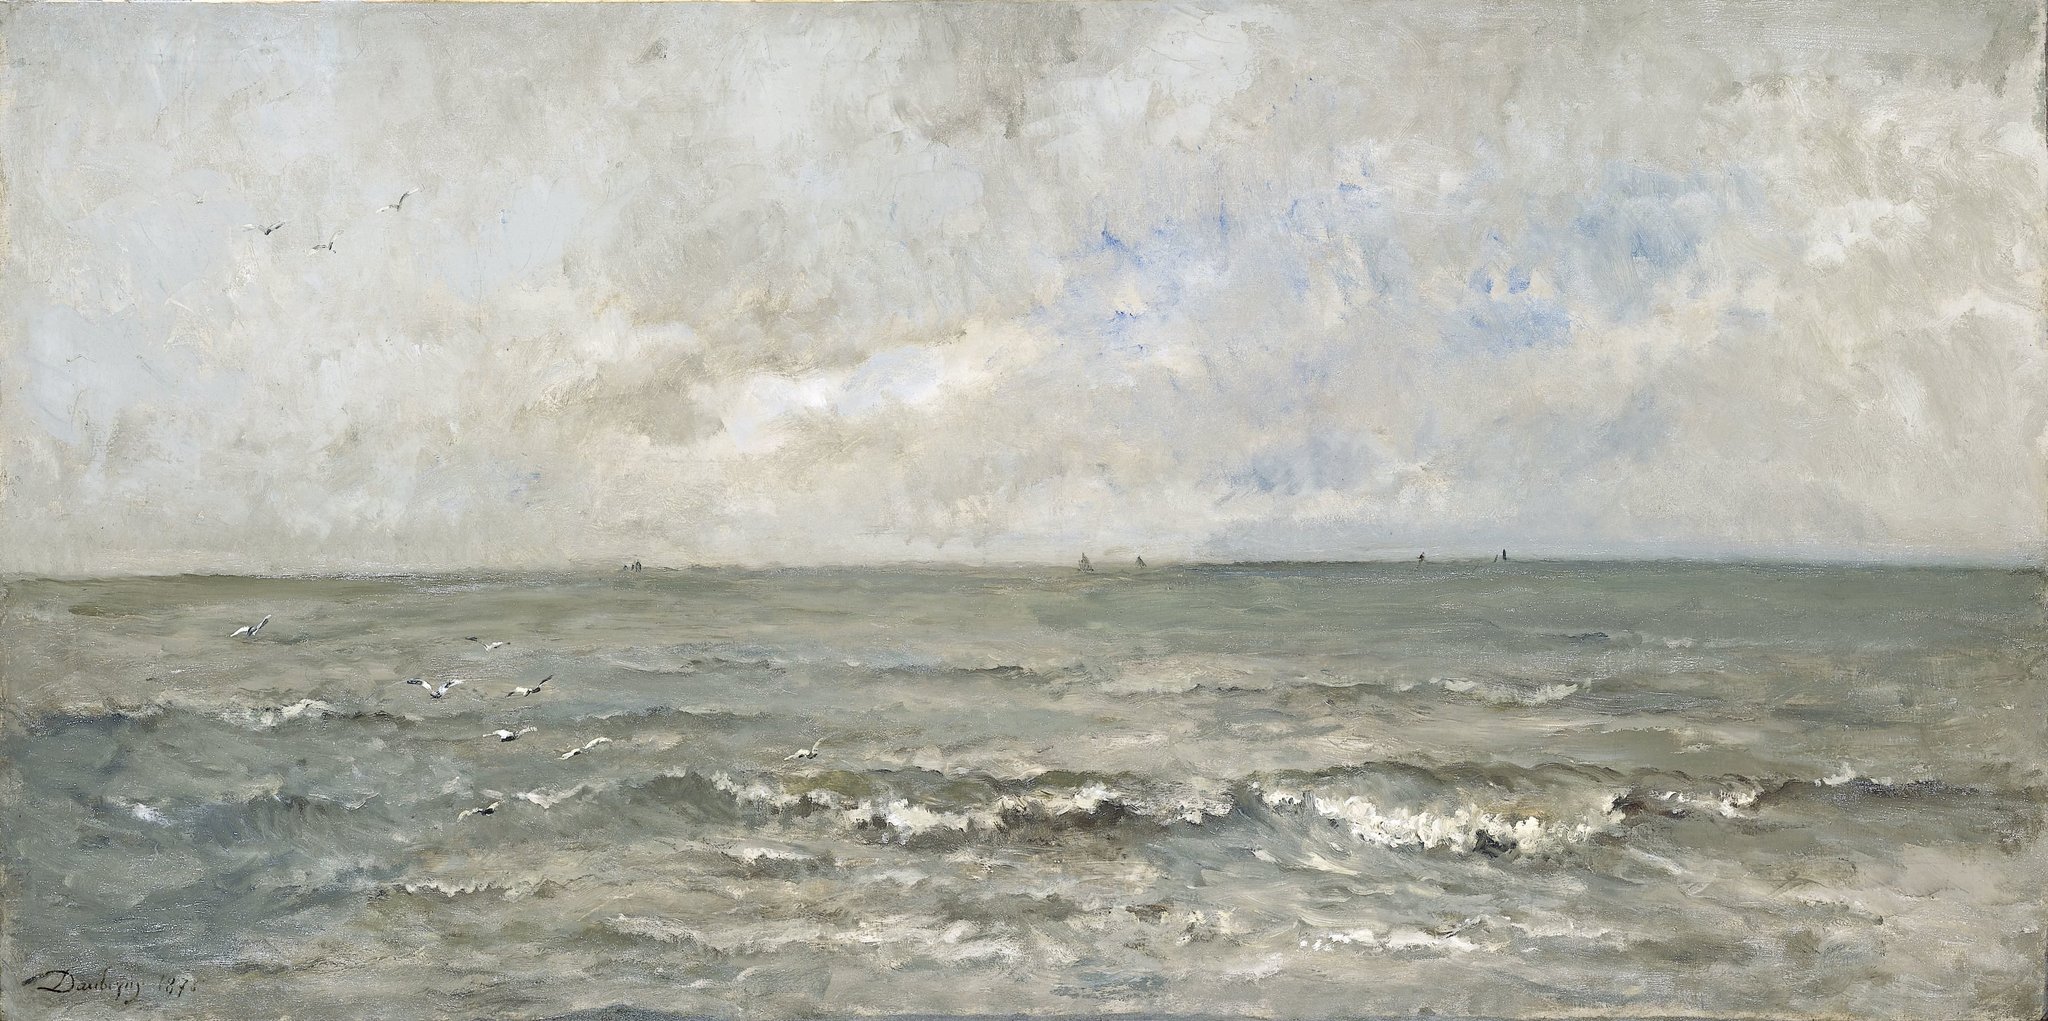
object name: painting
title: Seascape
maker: charles-françois daubigny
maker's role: draughtsman, painter, print maker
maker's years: 1817-1878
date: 1876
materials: canvas, oil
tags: sea (seascape)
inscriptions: signature and date: ‘Daubigny 1876’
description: Zeegezicht. Aanspoelende golven, in de verte vissersschepen.